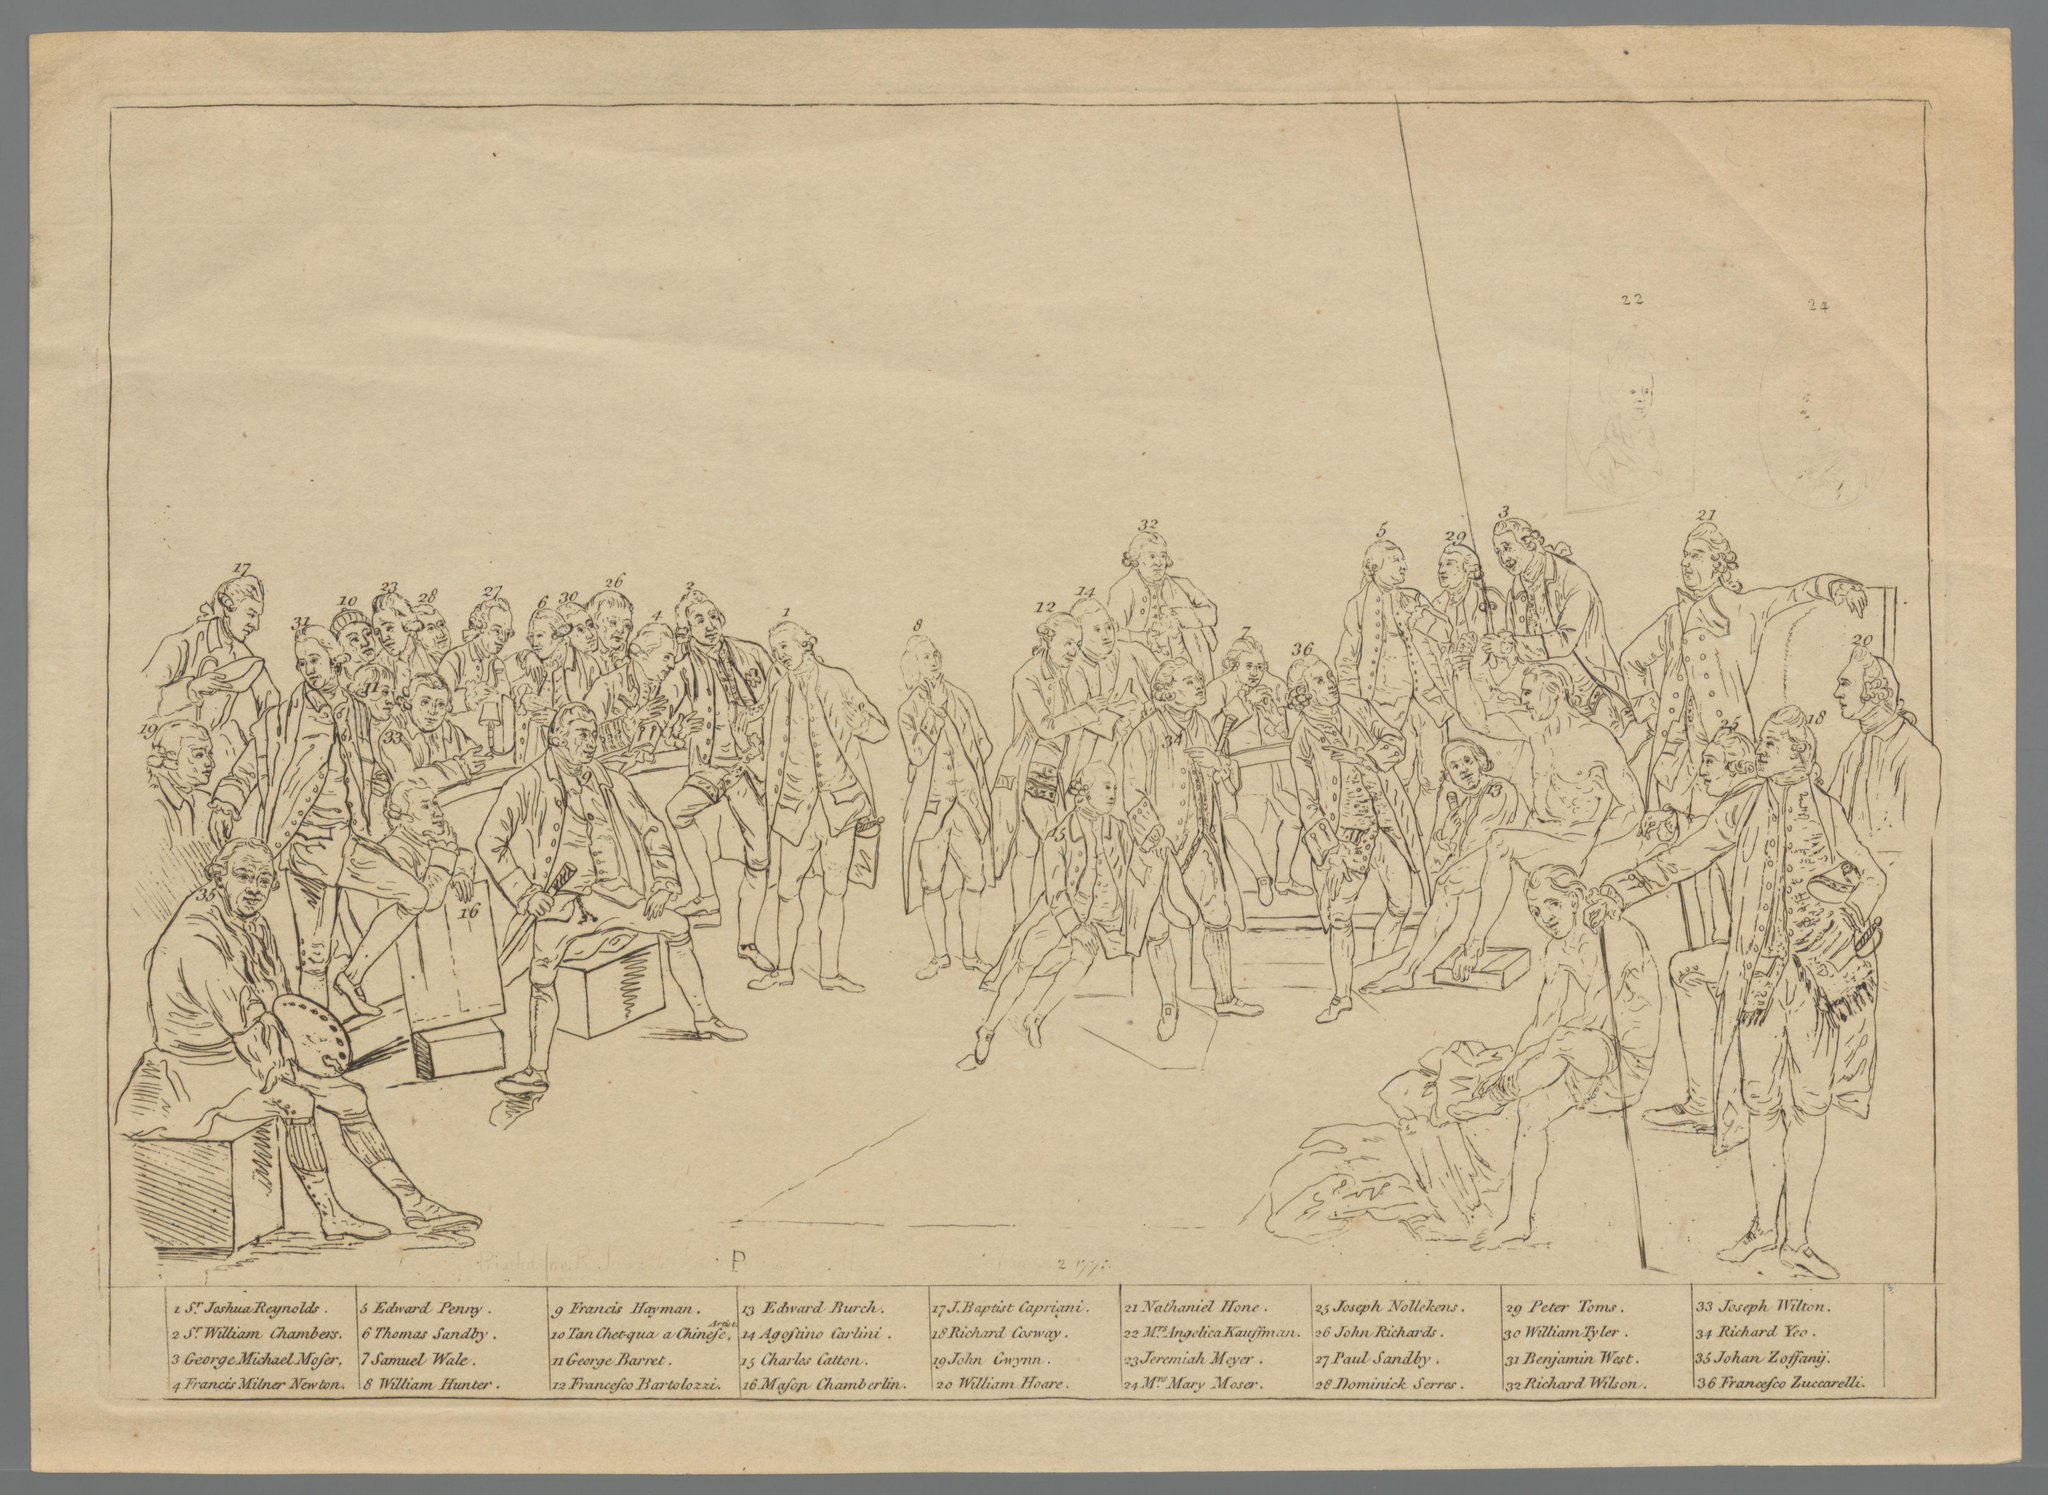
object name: print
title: Portretten van 36 leden van de Royal Academy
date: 1773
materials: paper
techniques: etching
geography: london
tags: historical persons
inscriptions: collector's mark: Lugt 209